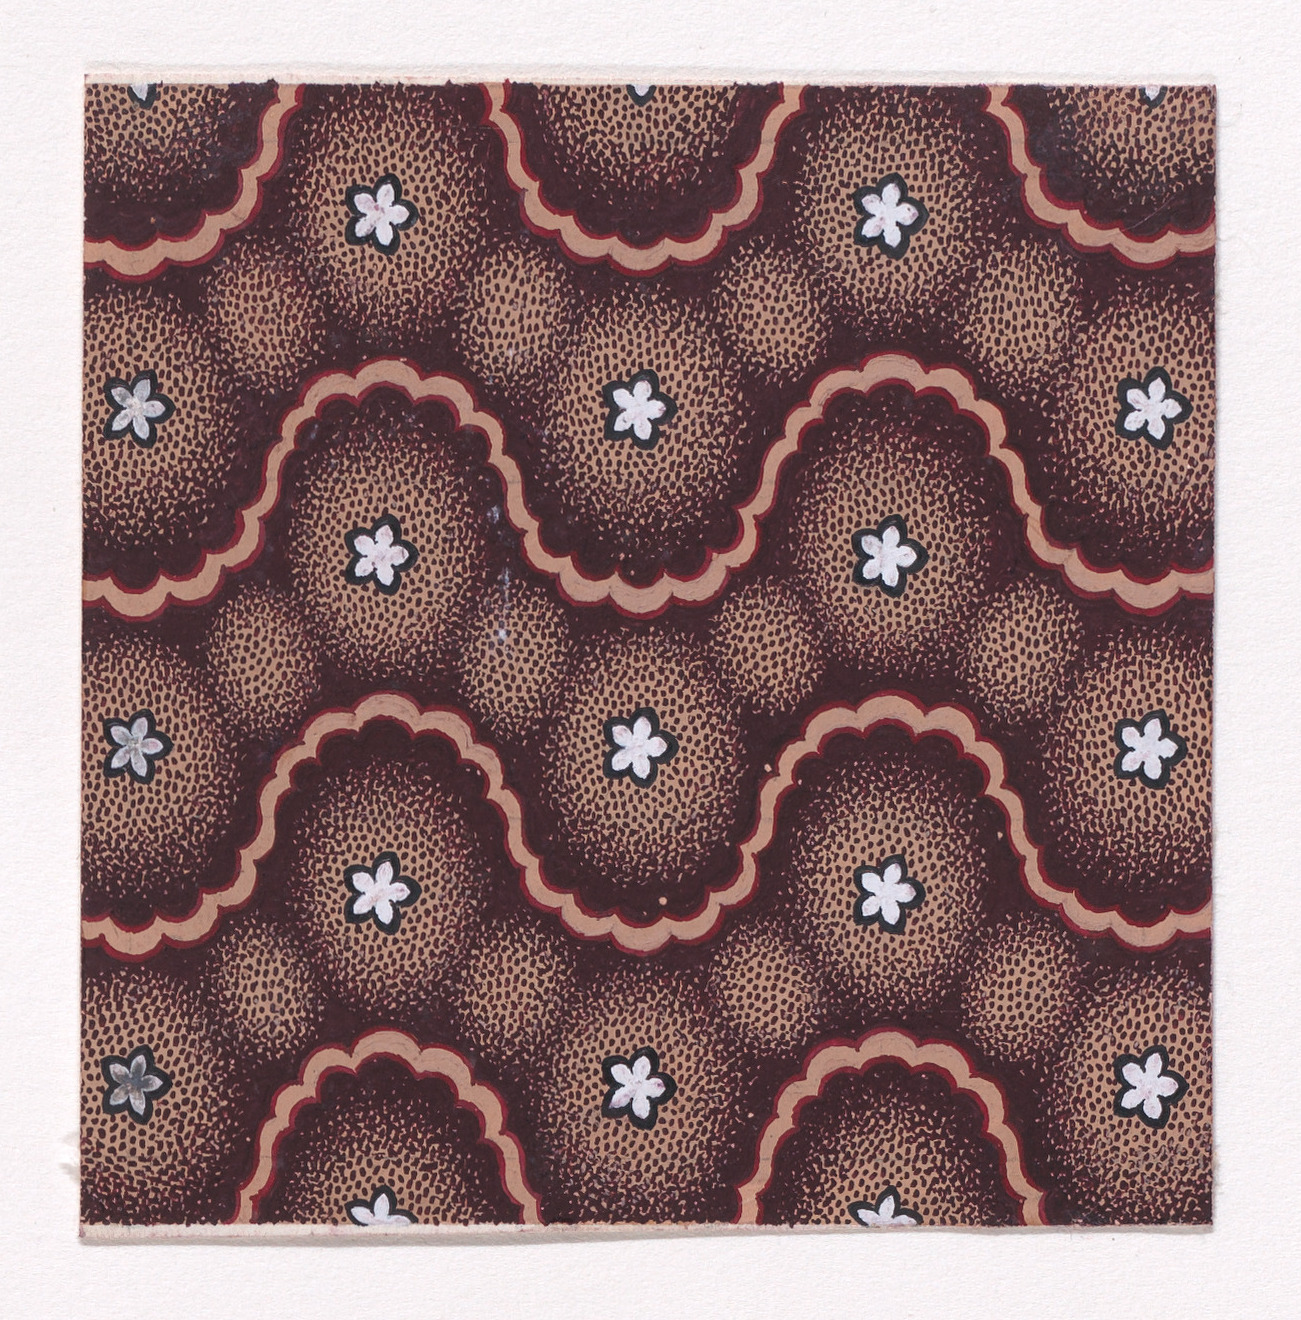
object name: drawing ornament architecture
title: Textile Design with Undulating Horizontal Strips of Rosettes Framed by Undulating Horizontal Ribbon Strips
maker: anonymous, alsatian, 19th century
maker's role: artist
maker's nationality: alsatian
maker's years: 1800-1900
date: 1840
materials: gouache